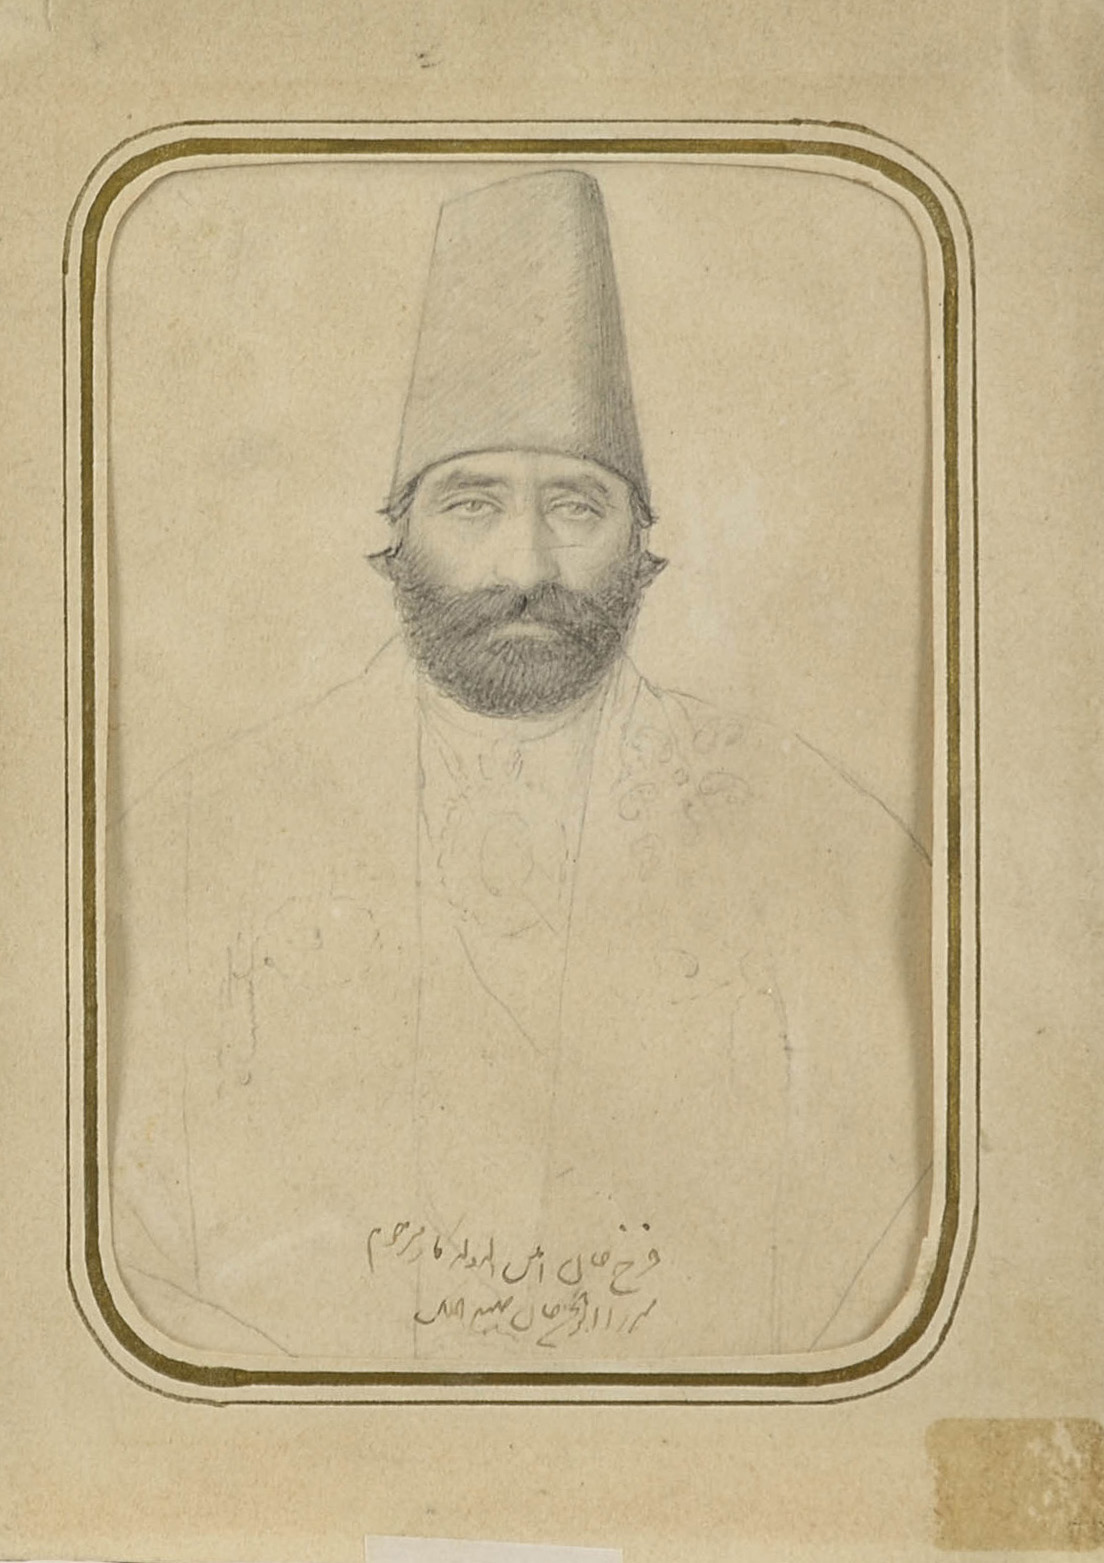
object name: illustrated single work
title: Portrait of Farrukh Khan Amin al-Dawla Kashi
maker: abu`l hasan ghaffari, known as sani' al-mulk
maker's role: artist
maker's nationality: iranian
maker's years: 1814-1866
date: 1834-1866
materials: graphite, paper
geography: iran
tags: men,portraits